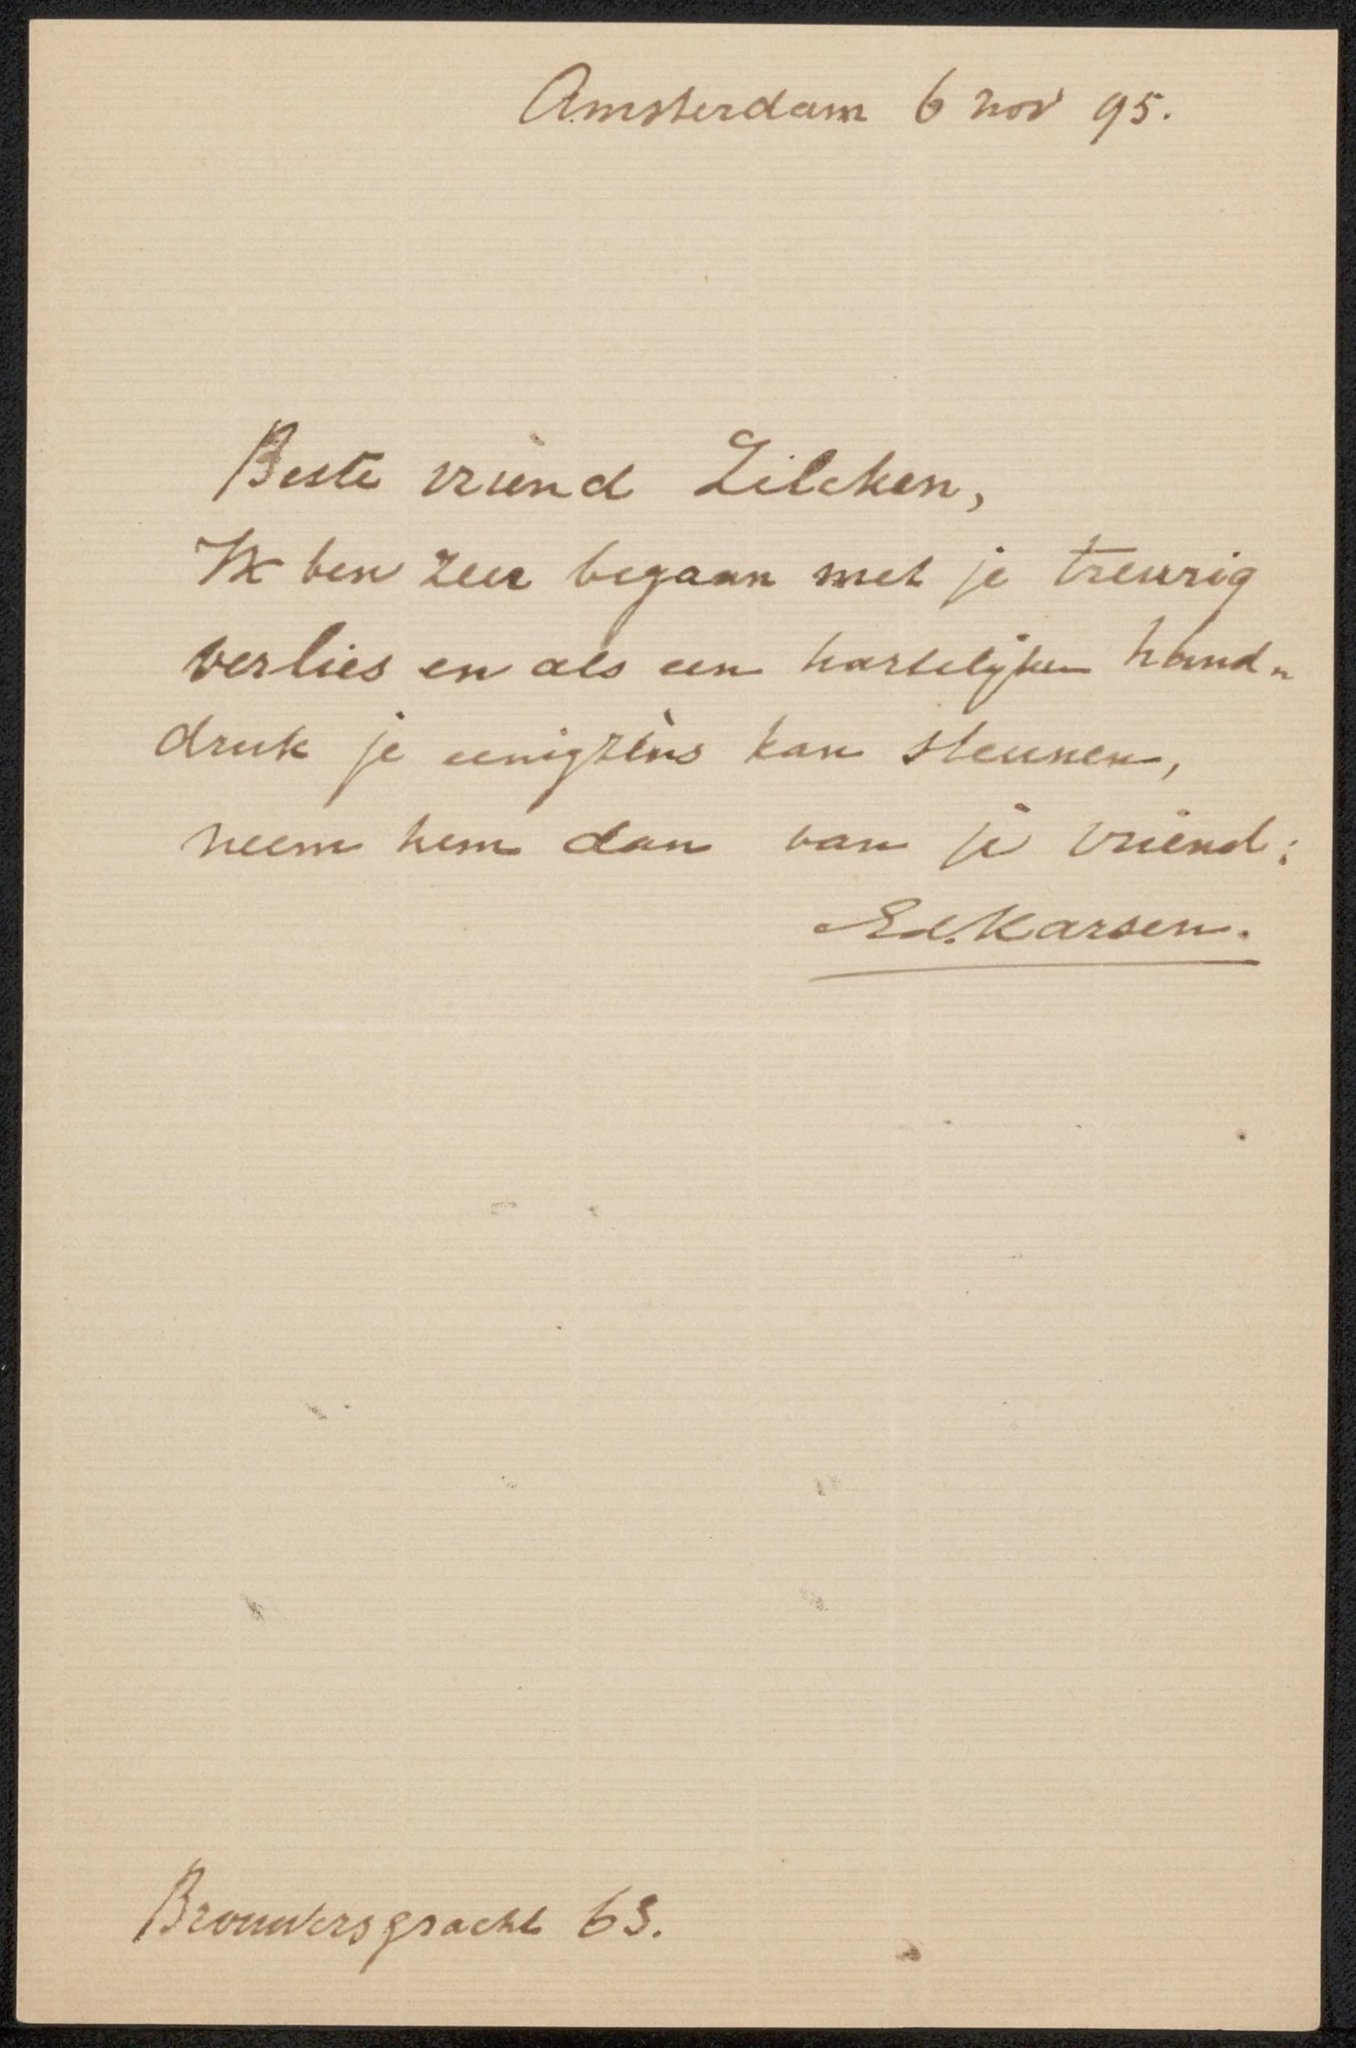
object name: letter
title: Brief aan Philip Zilcken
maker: eduard karsen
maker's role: draughtsman, painter, print maker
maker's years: 1860-1941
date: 1895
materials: ink, paper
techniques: pen, writing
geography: amsterdam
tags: brussels, helène lambertine hauzeur, philip zilcken, passions, emotions, affections